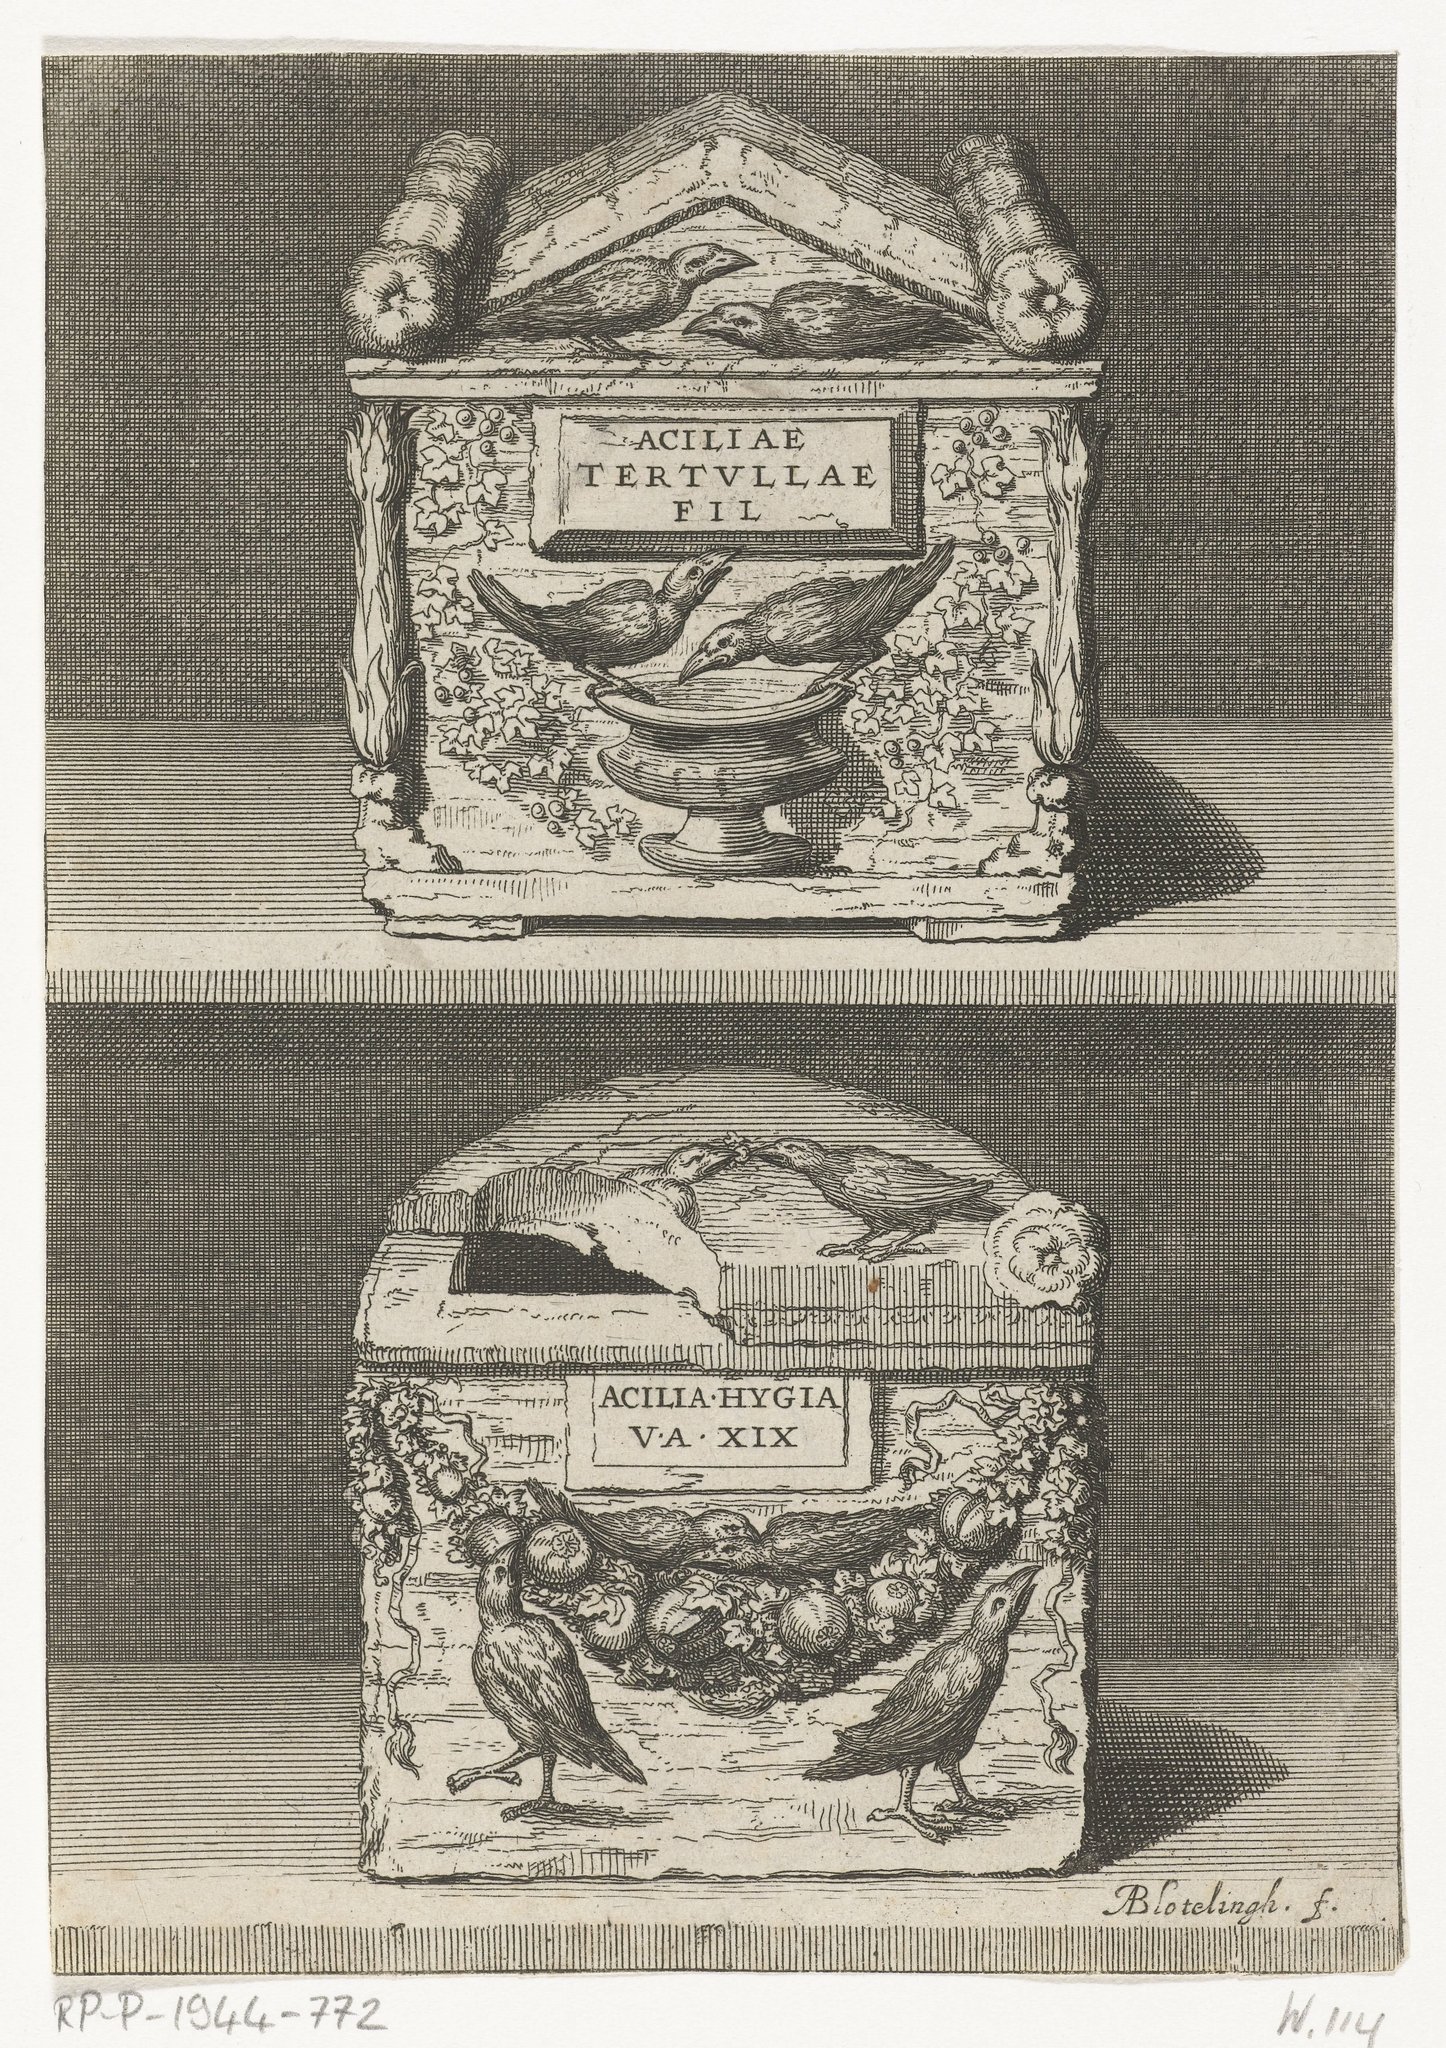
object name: print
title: Twee graftombes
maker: abraham bloteling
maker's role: draughtsman, print maker, publisher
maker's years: 1640-1690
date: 1655-1690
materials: paper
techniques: etching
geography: amsterdam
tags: grave, tomb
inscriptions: collector's mark: Lugt 2228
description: Twee antieke stenen graftombes met vogel- en bloemdecoraties. De deksel van de onderste tombe is beschadigd.